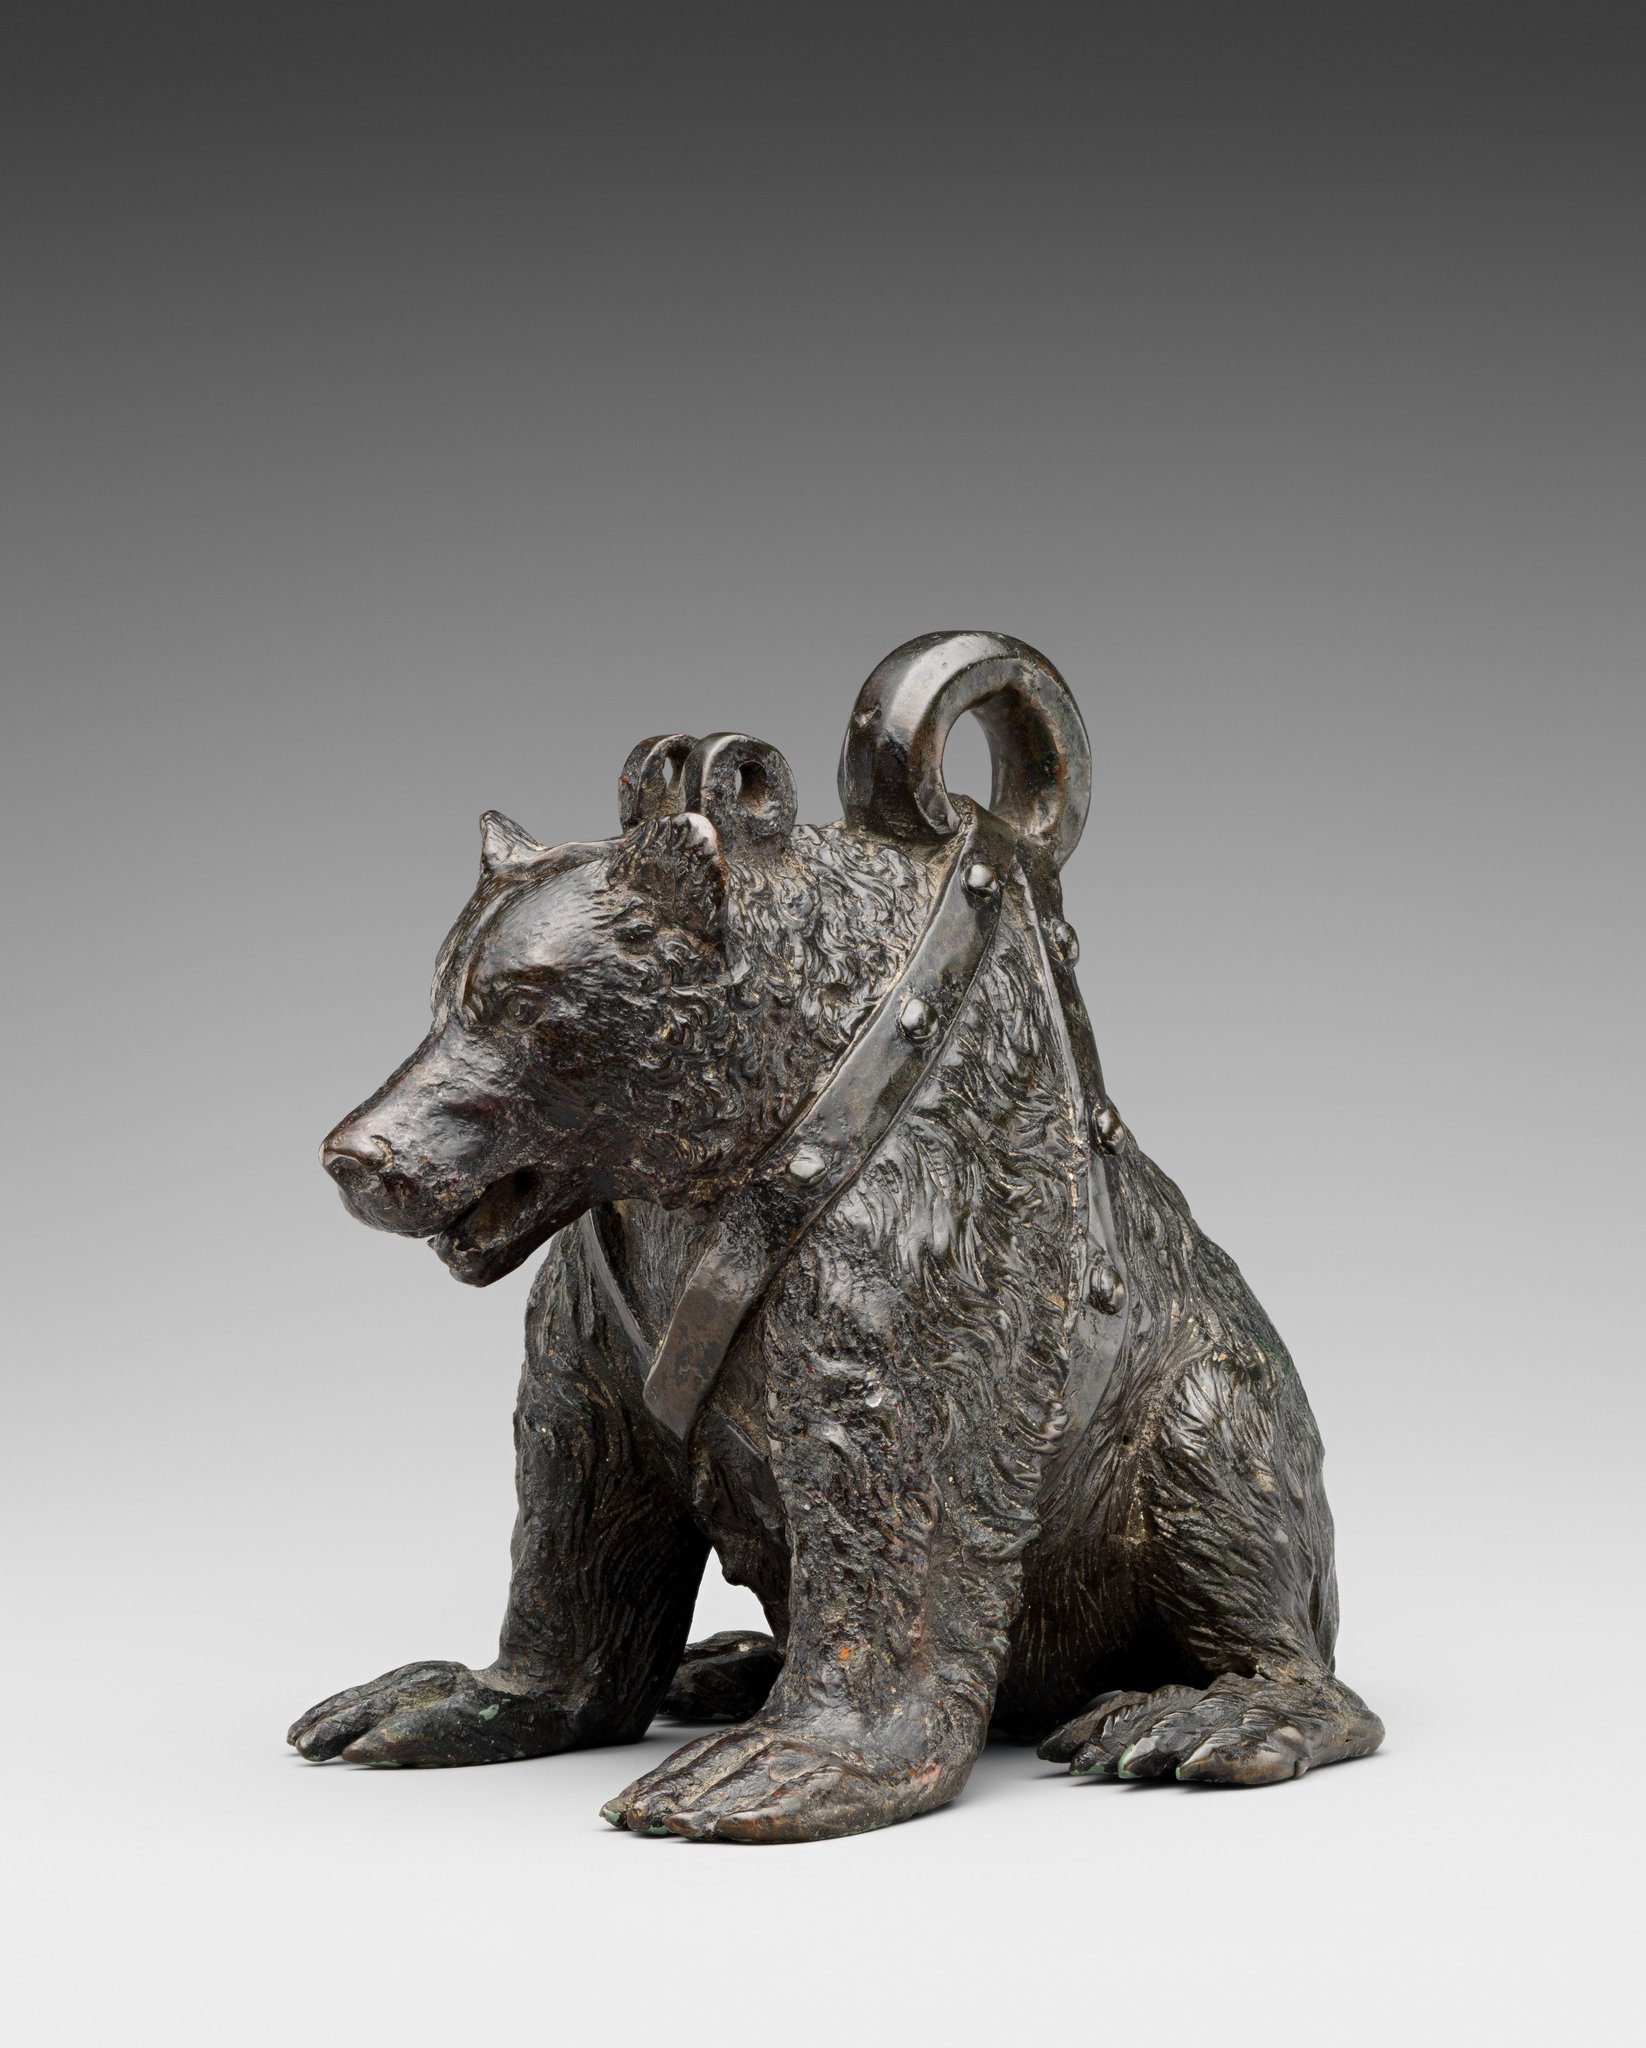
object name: statuette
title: She-bear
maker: andrea briosco, called riccio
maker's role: artist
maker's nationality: italian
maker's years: 1470-1532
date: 1501-1533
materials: bronze, patina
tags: bears